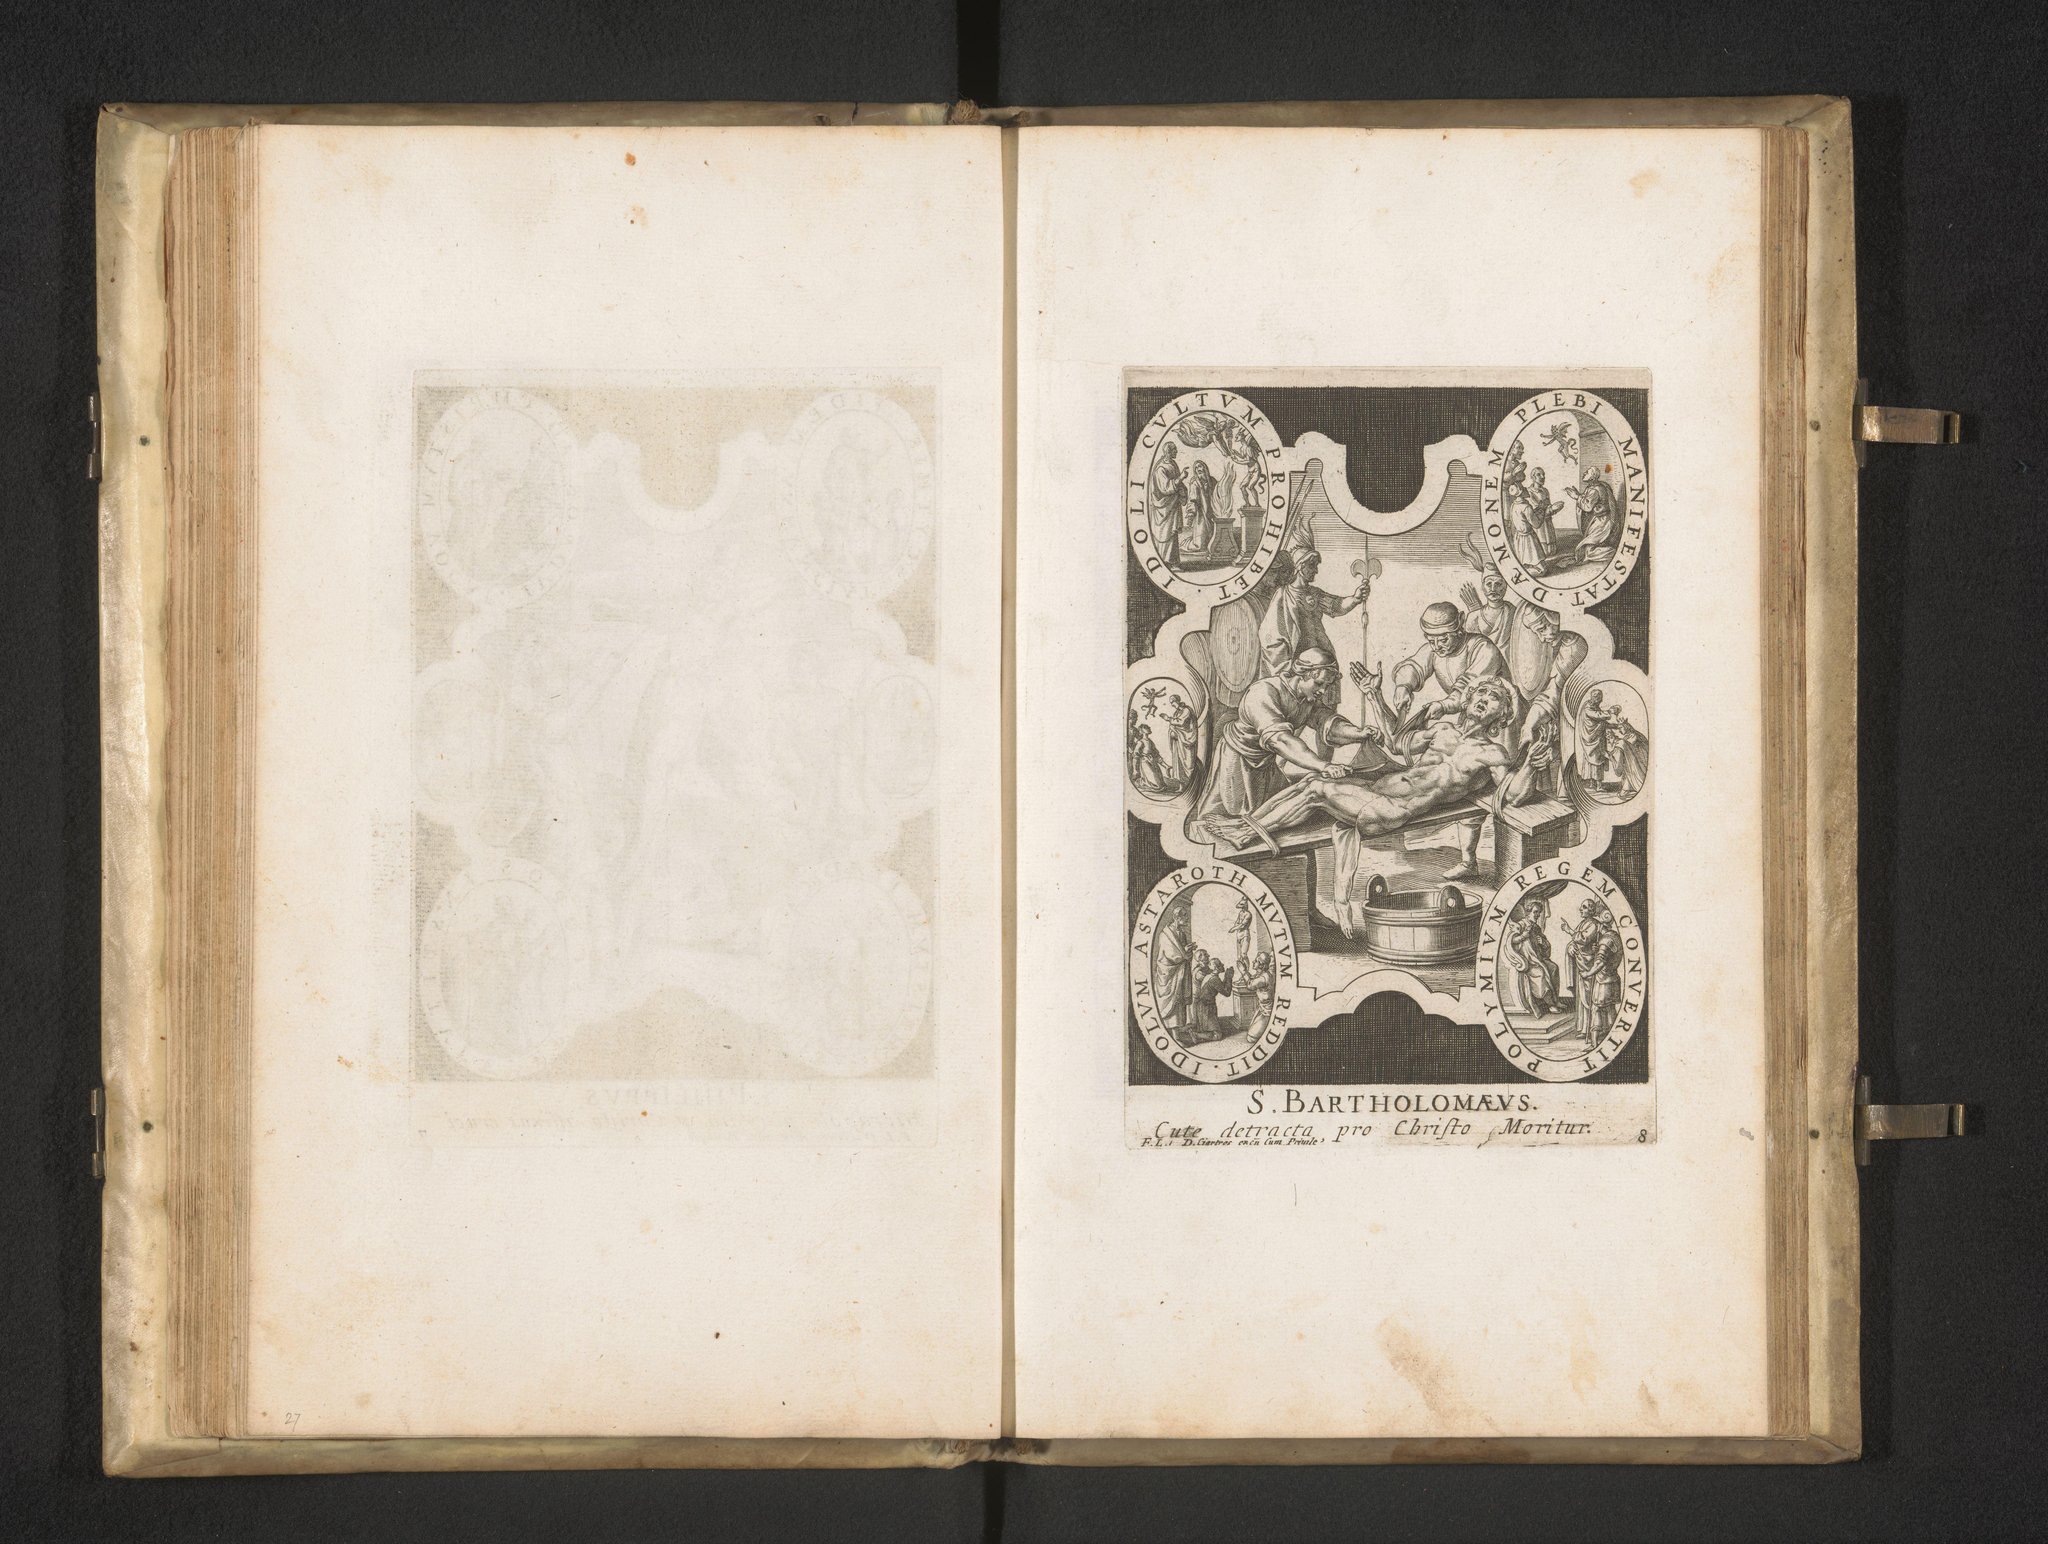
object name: print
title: S. Bartholomaeus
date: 1610-1647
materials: paper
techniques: engraving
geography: paris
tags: bartholomew flayed alive, the apostle bartholomew; possible attributes: book, devil or dragon at feet, knife, scroll, flayed skin, staff - martyrdom, suffering, misfortune, death of male saint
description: Martelaarschap van Bartolomeüs, in een kader met zes kleine scènes uit zijn leven. Onderdeel van een serie van twaalf voorstellingen van het martelaarschap van de apostelen. Onderdeel van een album met voornamelijk christelijke voorstellingen.